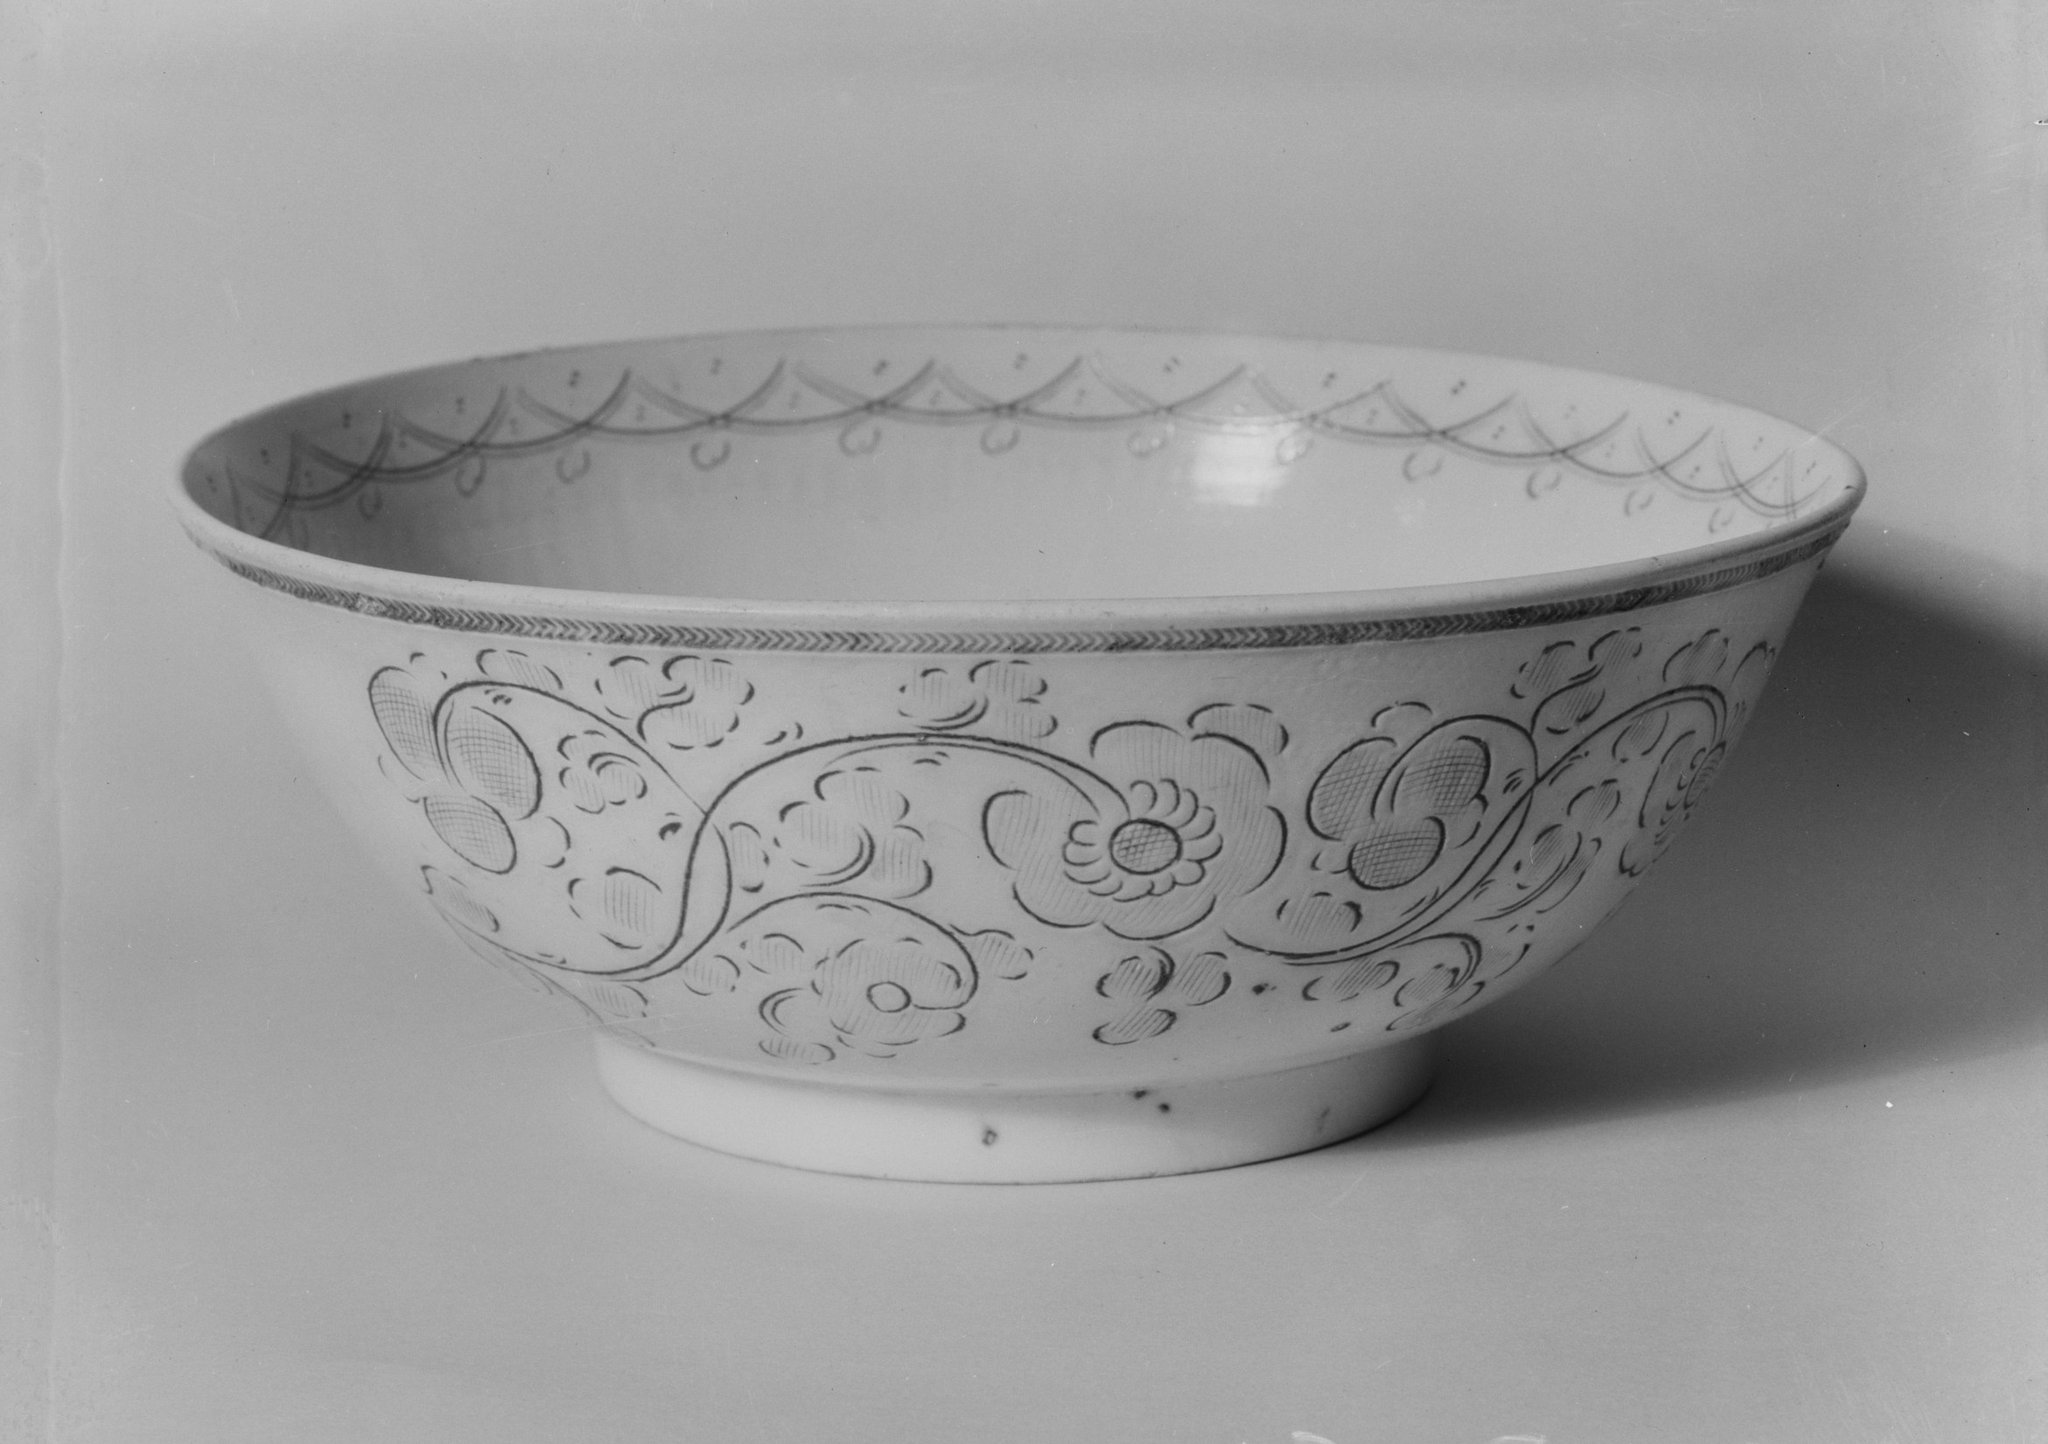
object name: bowl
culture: british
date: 1750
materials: stoneware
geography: england